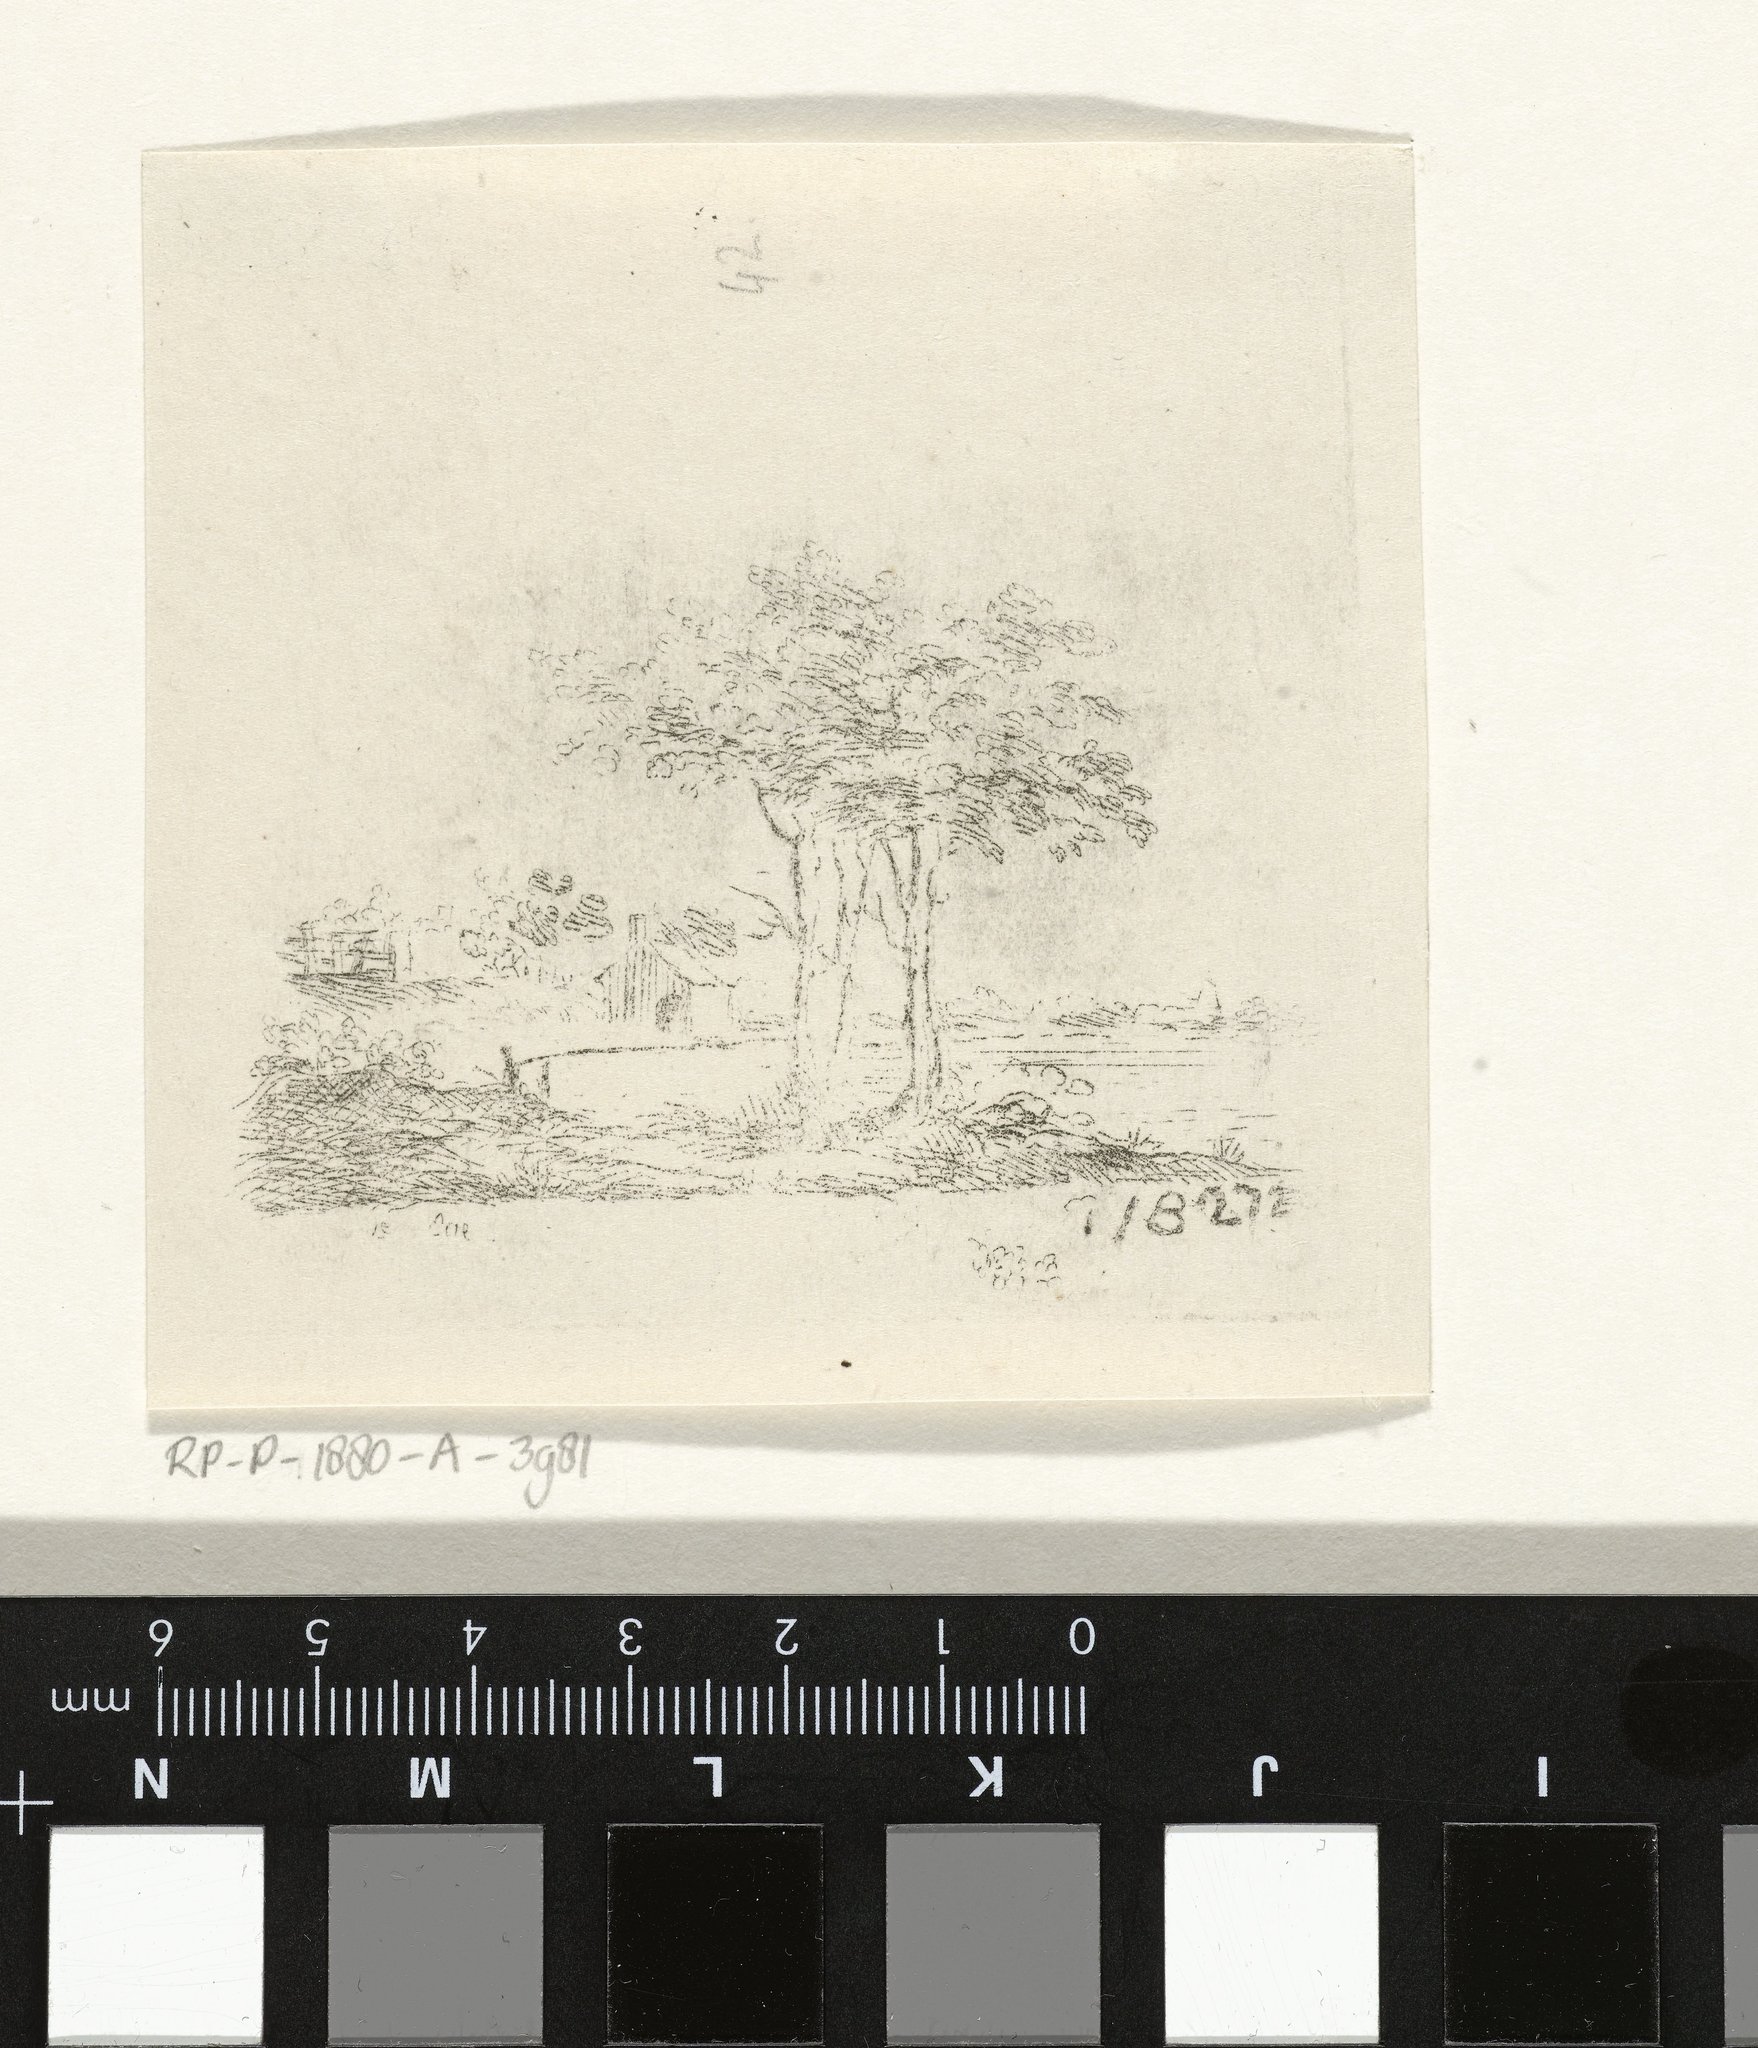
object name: print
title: Landschap met twee bomen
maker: reinierus albertus ludovicus baron van isendoorn à blois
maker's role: print maker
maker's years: 1786-1856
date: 1827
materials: paper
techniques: etching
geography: vaassen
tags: trees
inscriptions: collector's mark: Lugt 2228